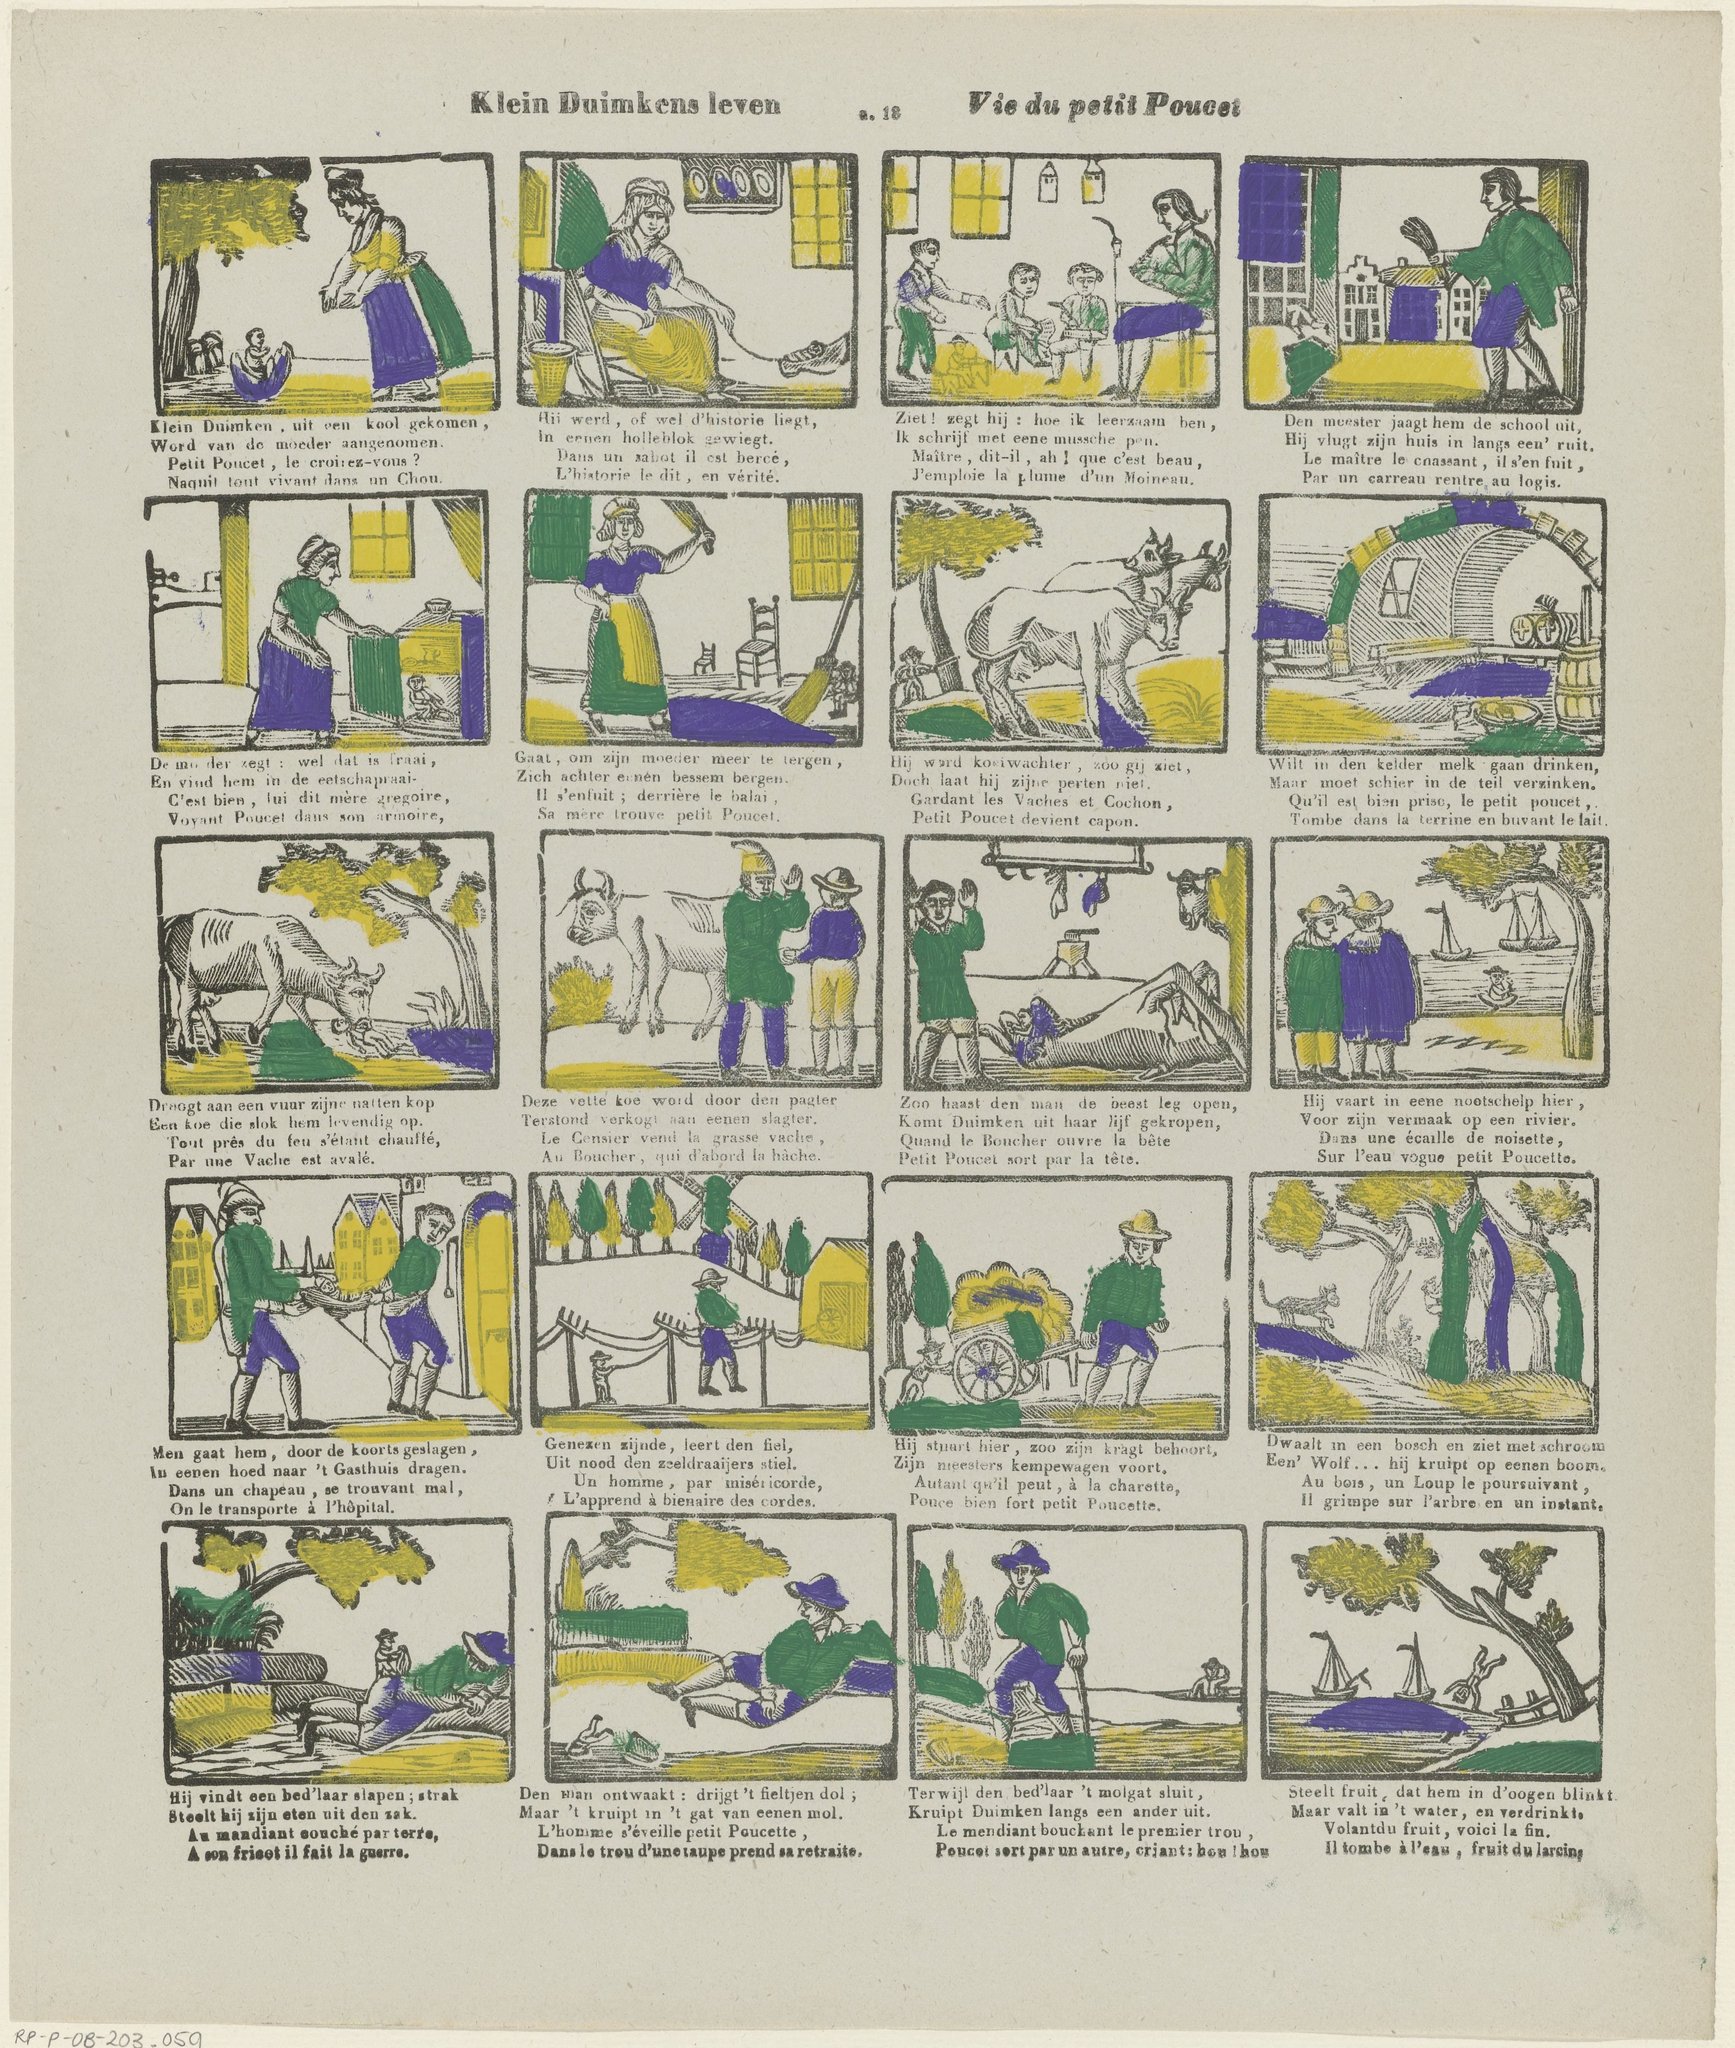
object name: print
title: Klein Duimkens leven / Vie du petit Poucet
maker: Anonymous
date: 1856-1900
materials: paper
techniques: colour, letterpress printing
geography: turnhout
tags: tales and fairy tales: little thumbling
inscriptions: collector's mark: Lugt 2760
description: Blad met 20 voorstellingen uit het sprookje van Klein Duimpje. Onder elke afbeelding een tweeregelig vers in het Nederlands en in het Frans. Genummerd midden boven: n. 18.